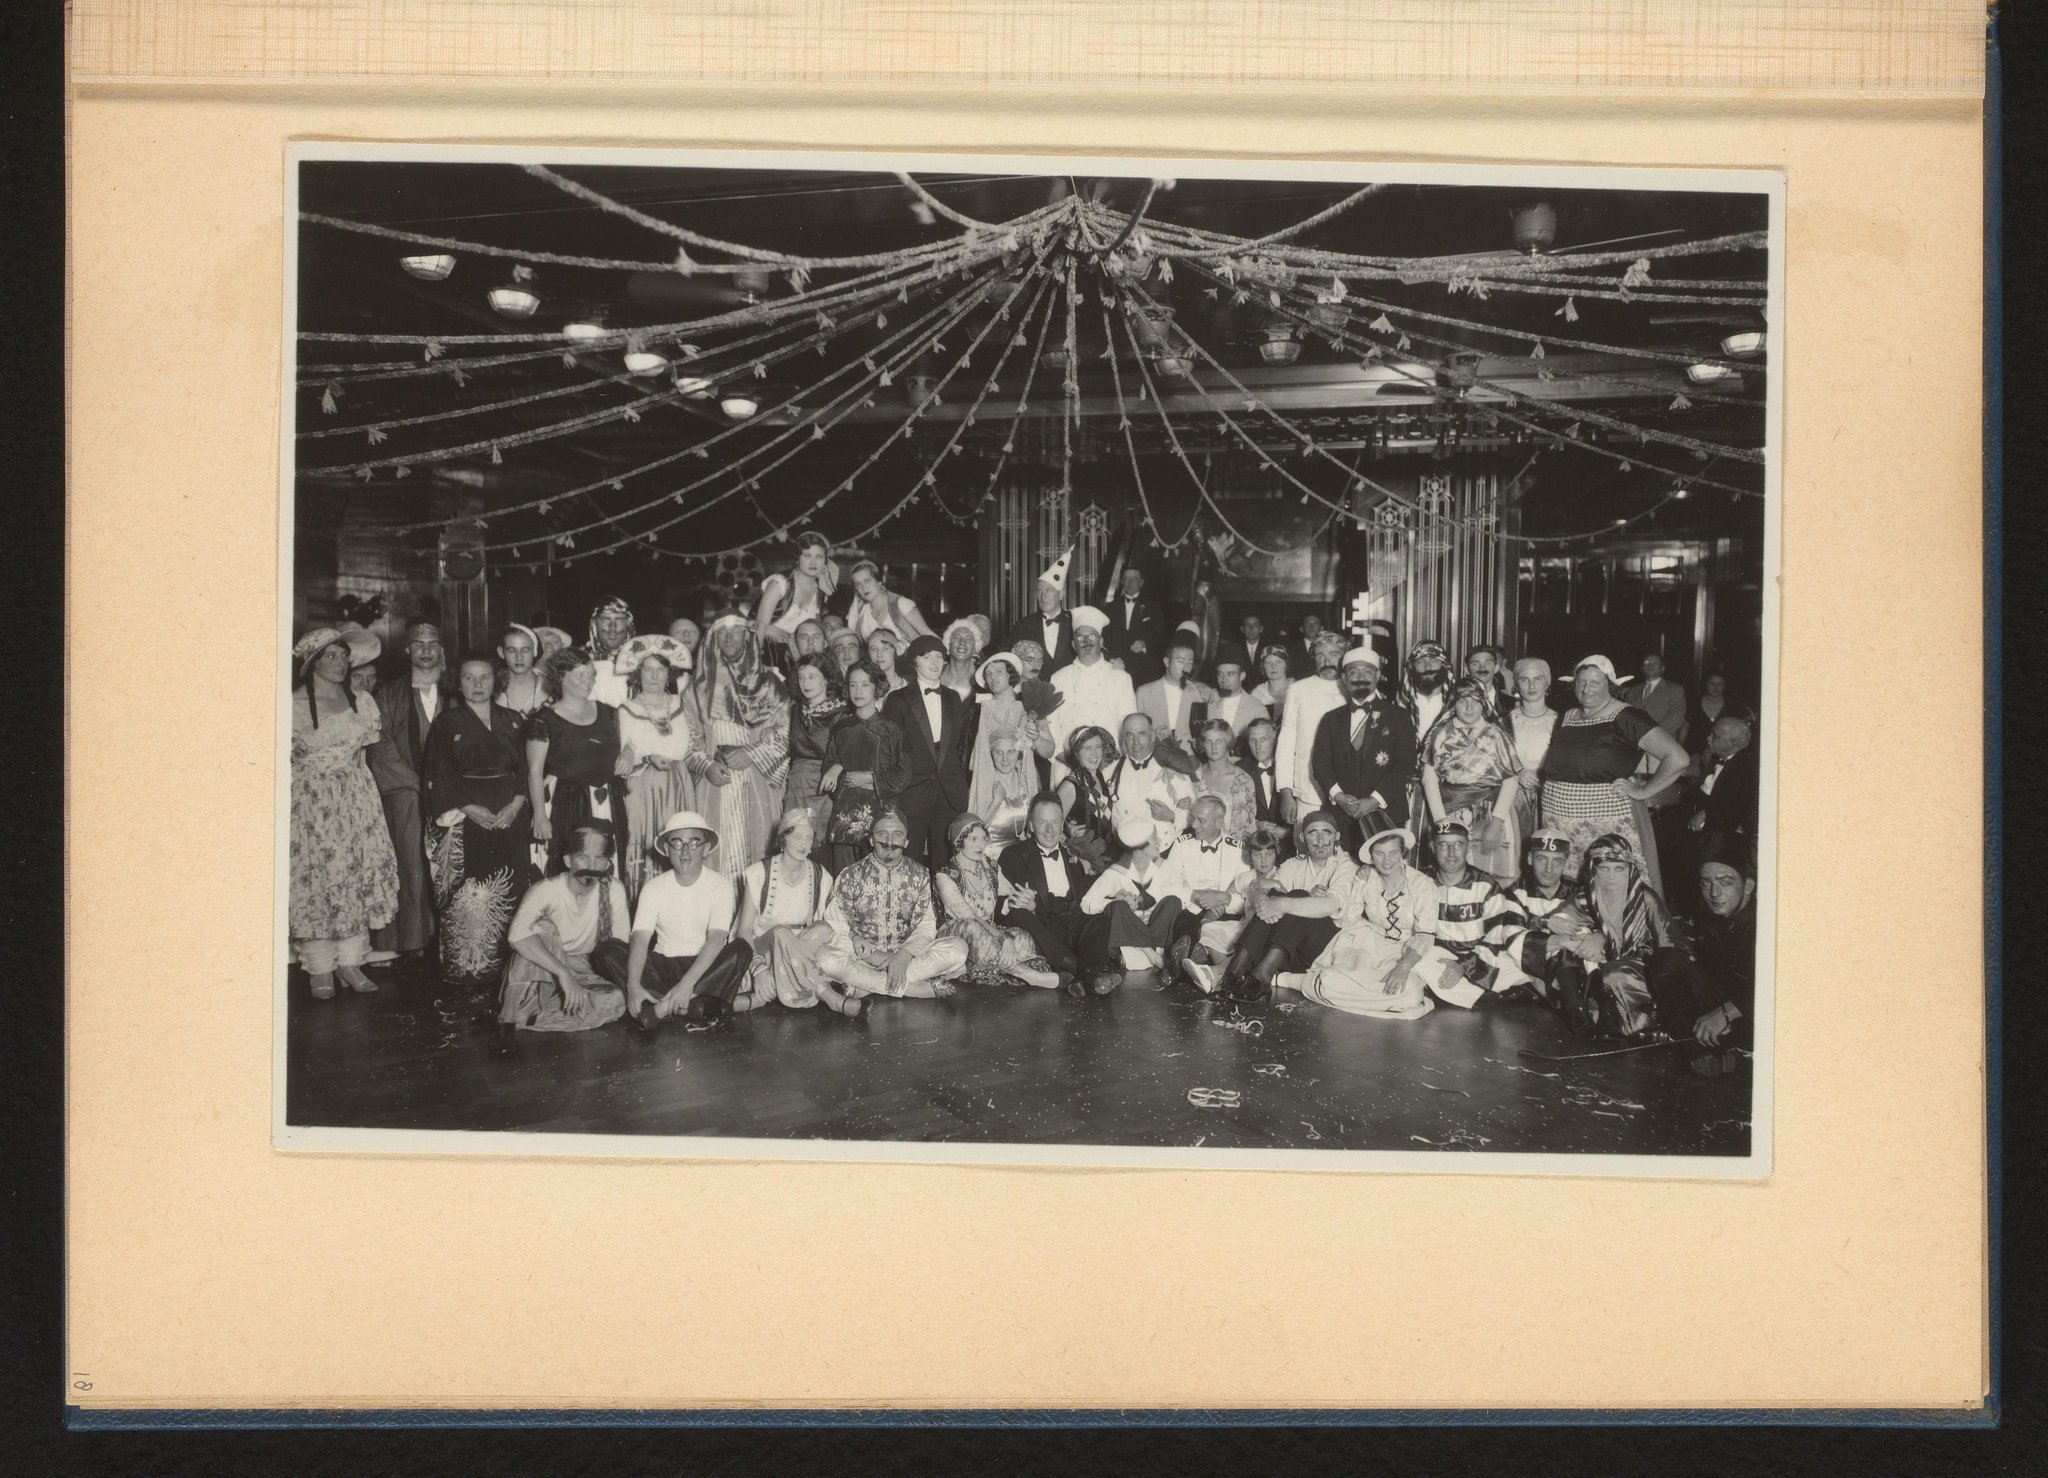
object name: photograph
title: Gekostumeerd bal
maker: Anonymous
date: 1930-1940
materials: cardboard, photographic support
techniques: gelatin silver print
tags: surabaya, paris, beatrice jacqueline eveline dumas, historical persons - bb - woman, masquerade, masked ball, netherlands, dutch east indies, the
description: Groepsfoto op een gekostumeerd bal, centraal Eef gearmd met een vriendin. Onderdeel van het fotoalbum van Beatrice Jacqueline Eveline (Eef) Dumas, ca. 1880-1952.